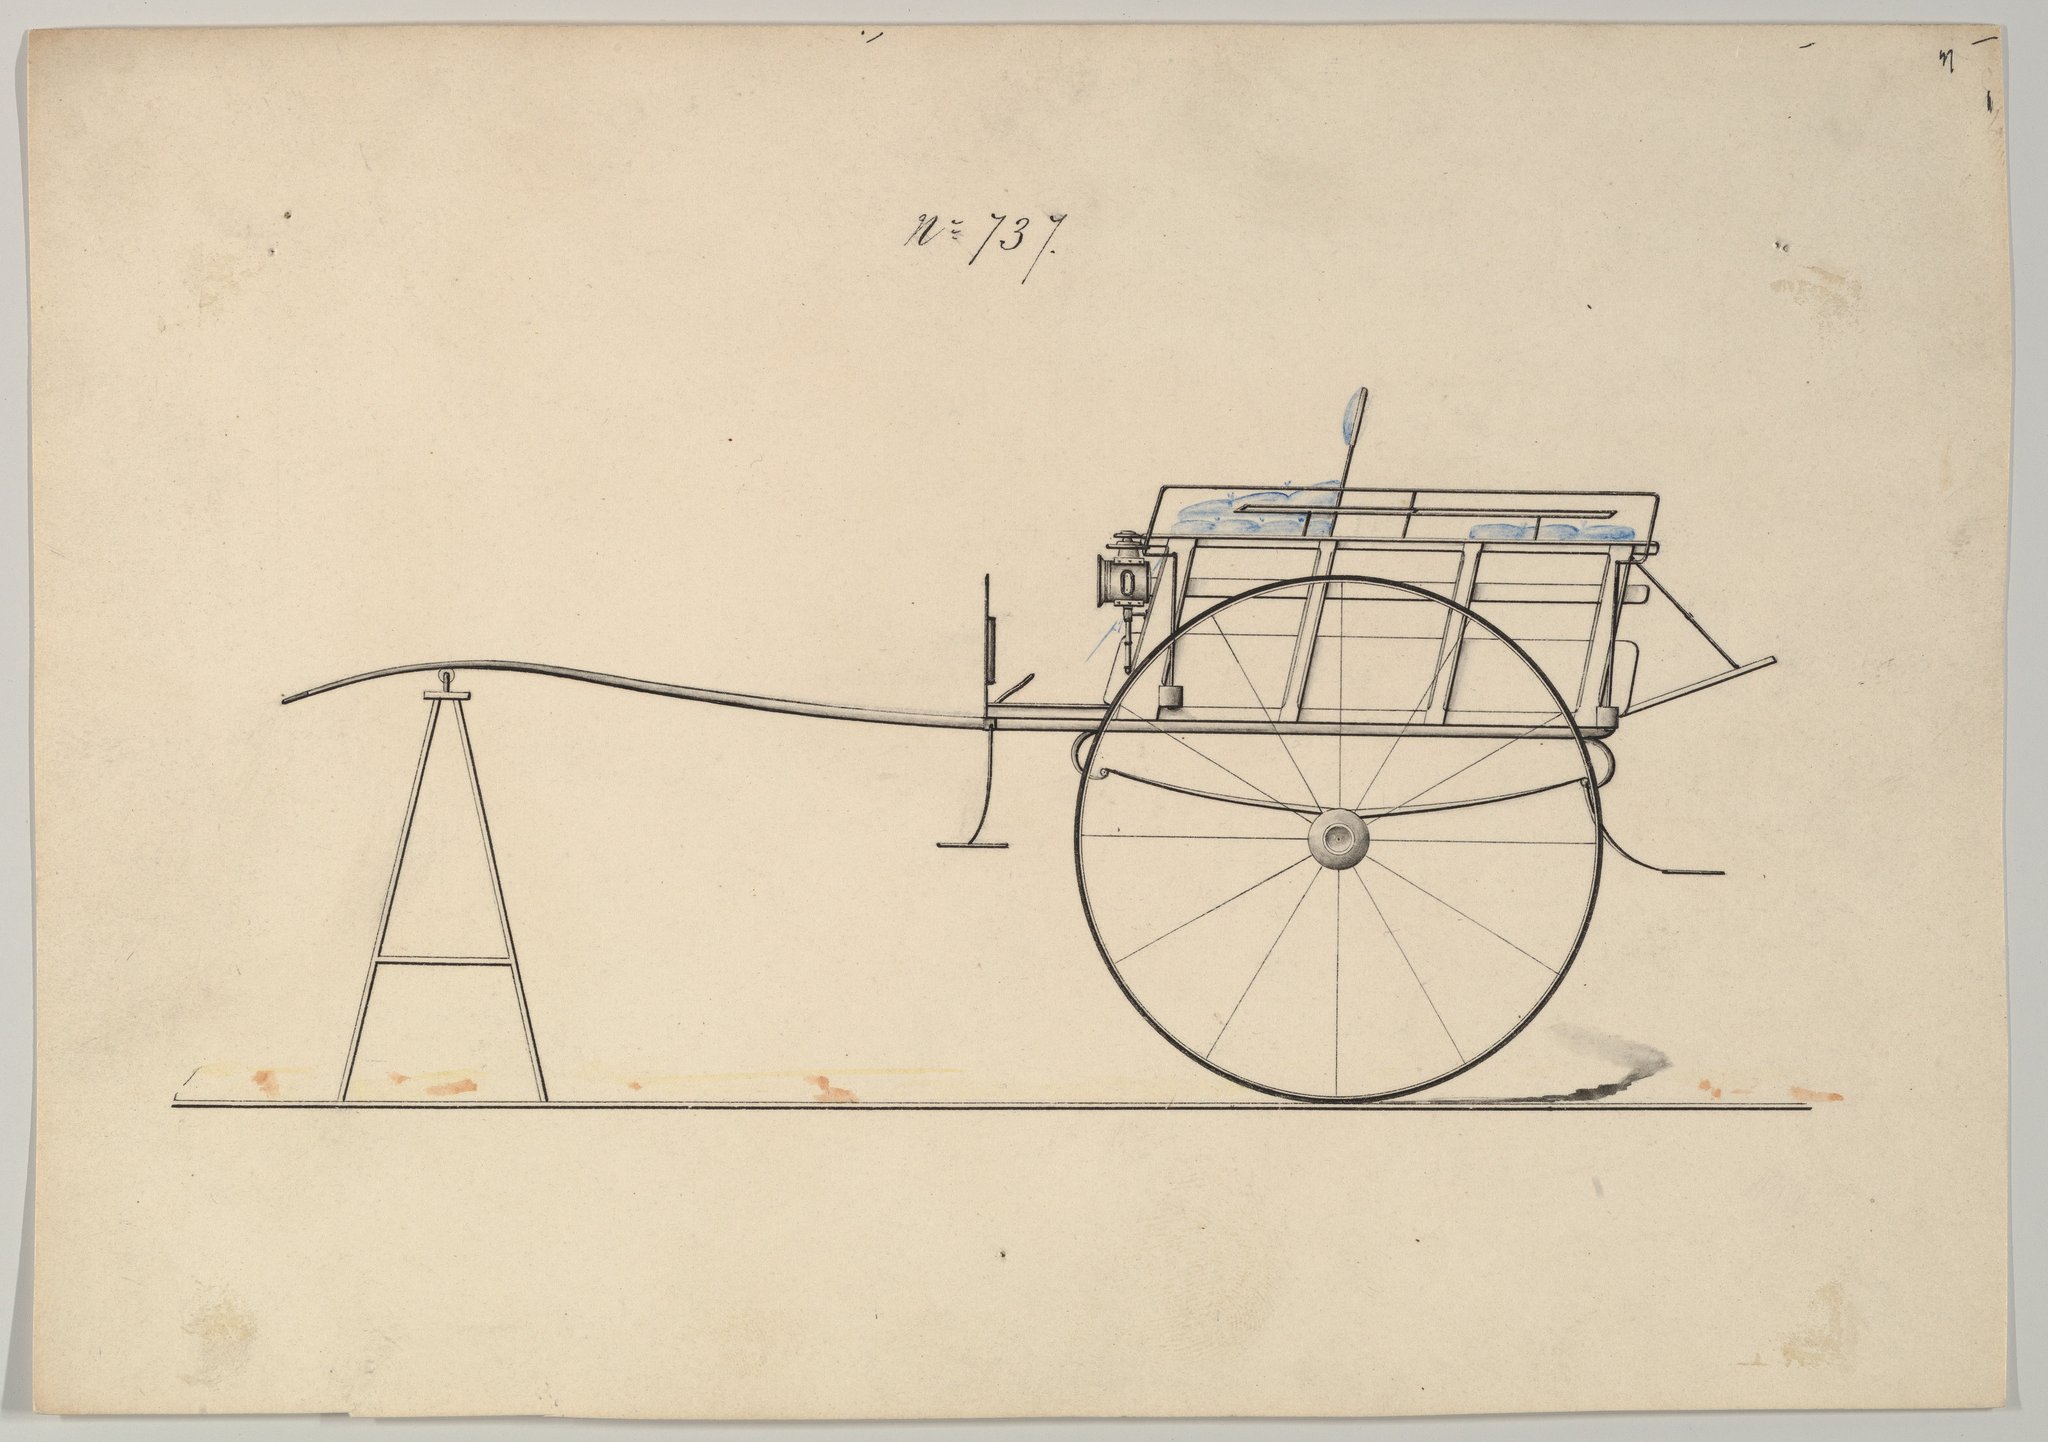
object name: drawing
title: Game Cart #737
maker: brewster & co.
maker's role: manufacturer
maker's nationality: american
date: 1860-1870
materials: ink, watercolor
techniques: pen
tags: carriages